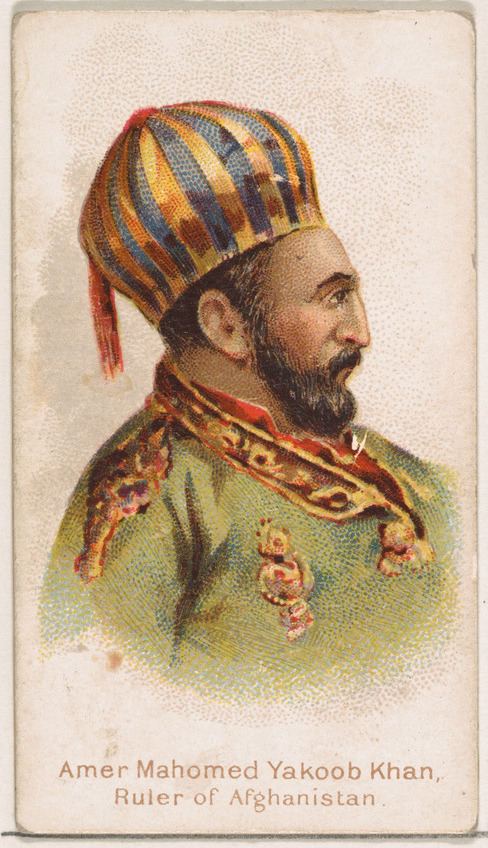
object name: print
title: Amer Mahomed Yakoob Khan, Ruler of Afghanistan, from the Savage and Semi-Barbarous Chiefs and Rulers series (N189) issued by Wm. S. Kimball & Co.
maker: william s. kimball & company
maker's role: publisher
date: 1888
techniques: color lithograph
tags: men,profiles